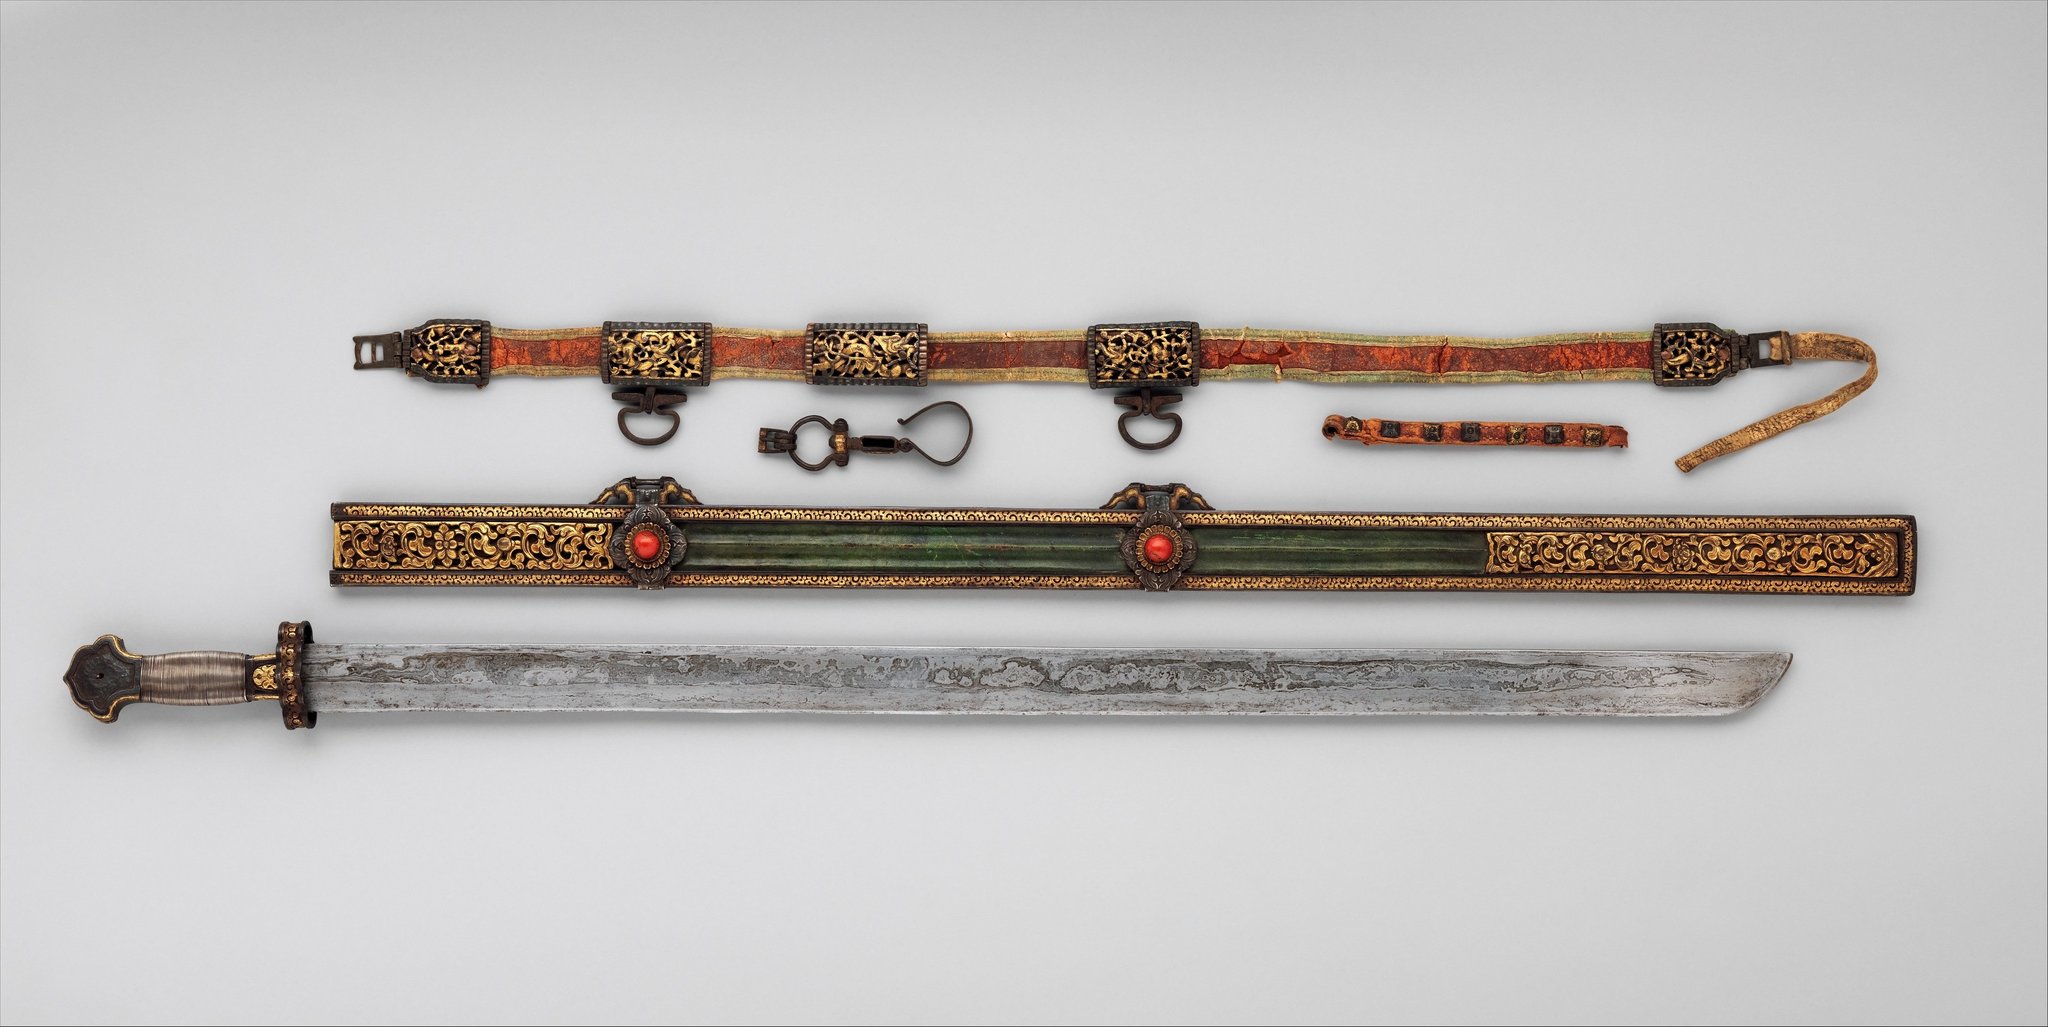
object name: sword, scabbard, and belt hook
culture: tibetan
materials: copper, coral, gold, leather, silver, steel, wood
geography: tibet